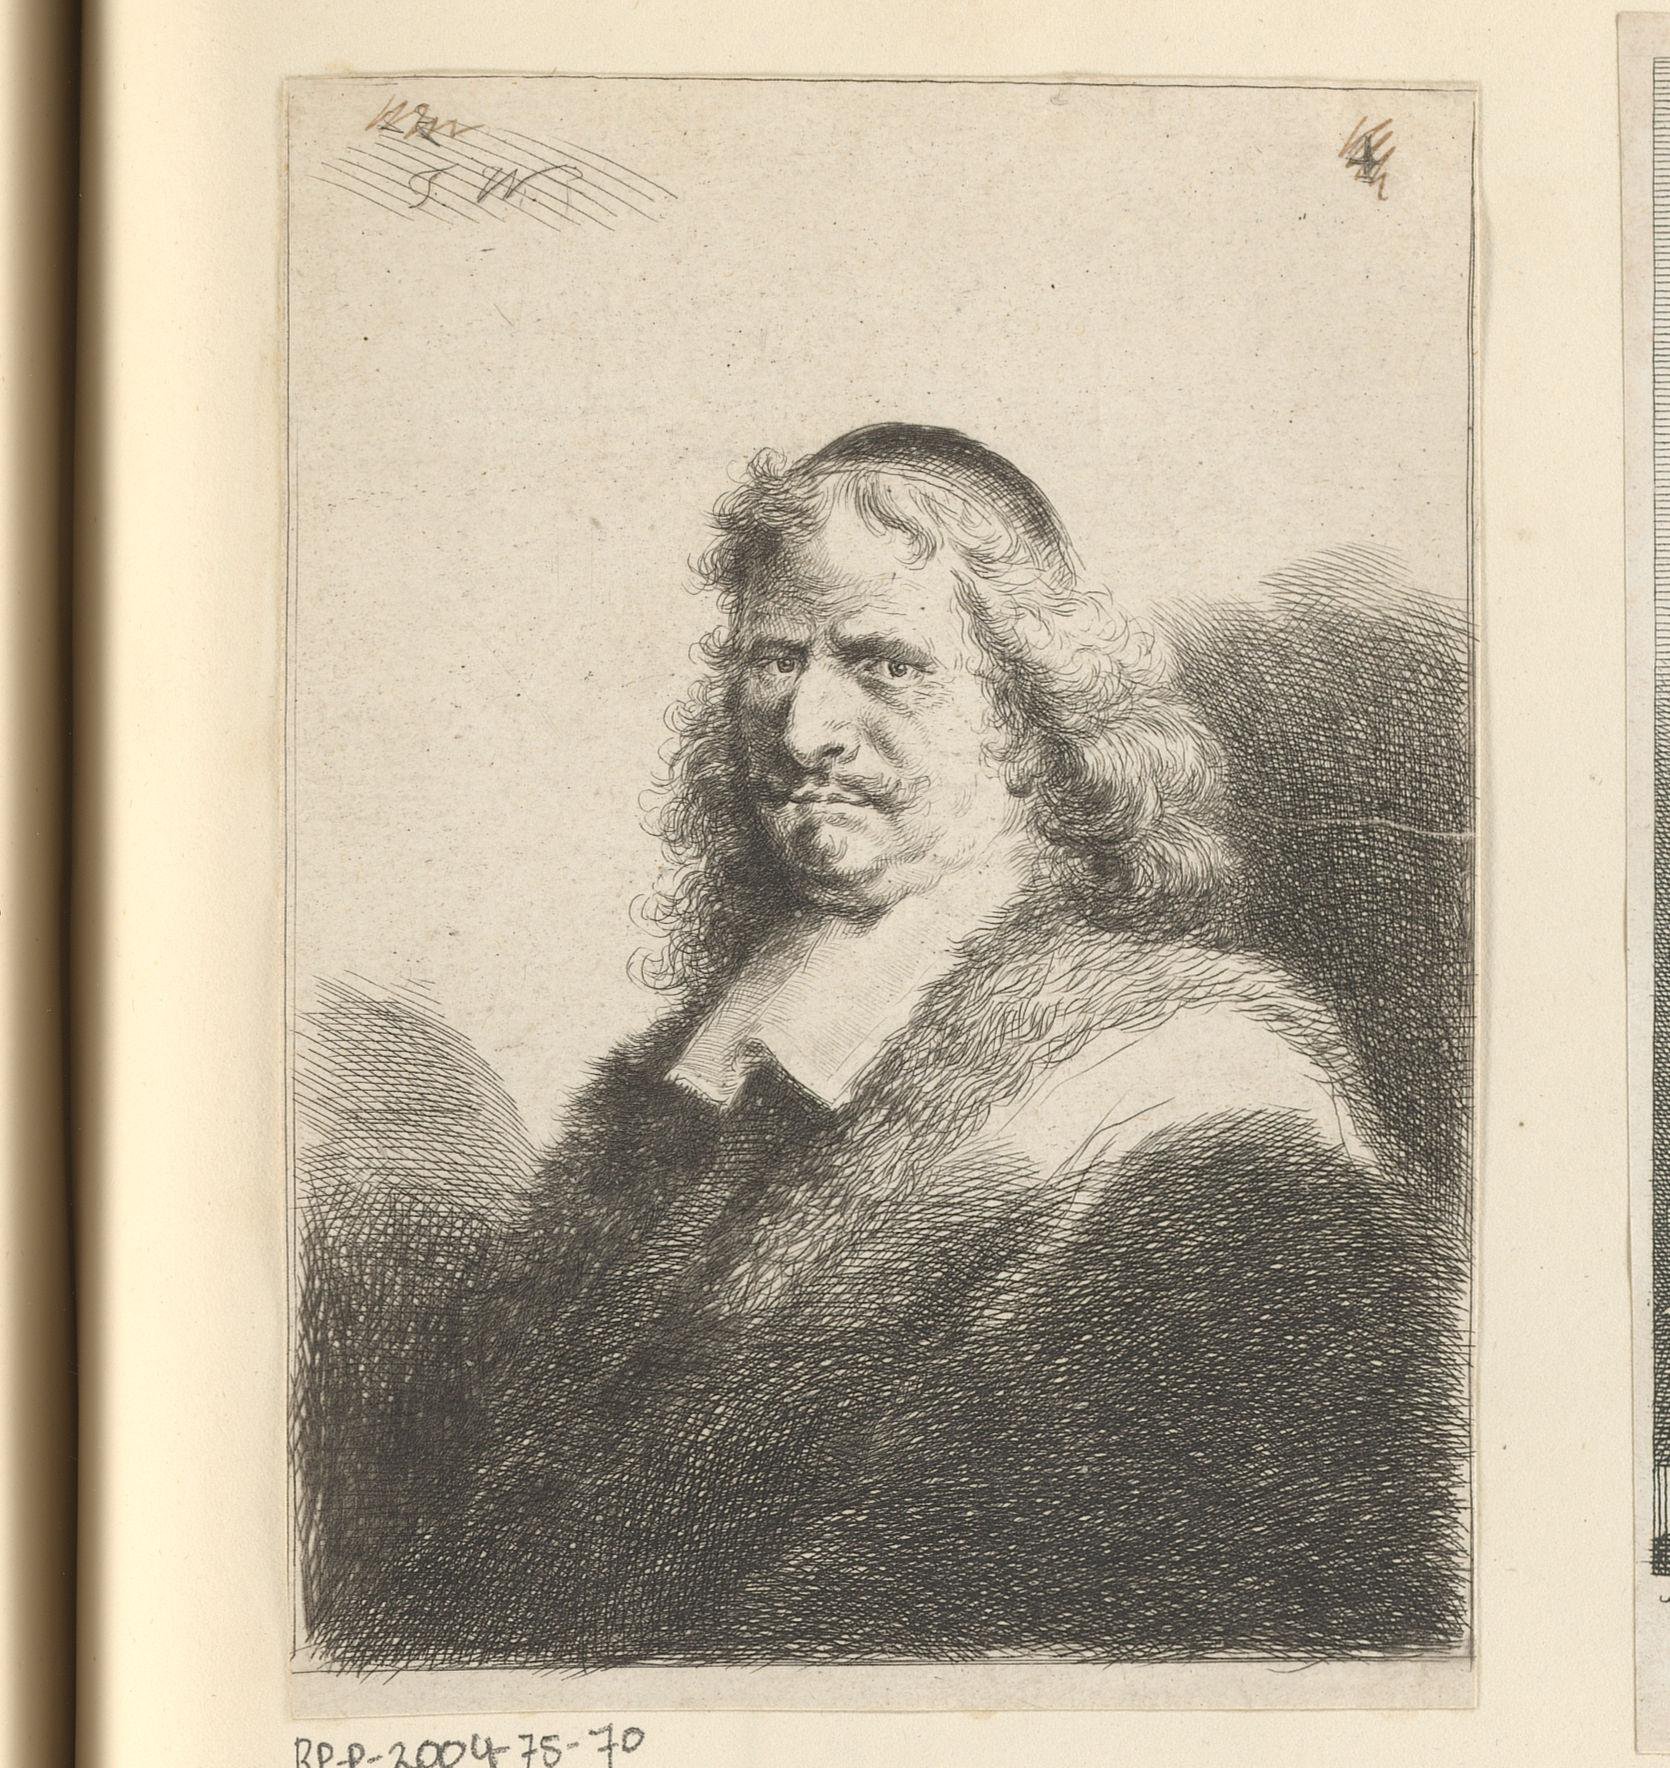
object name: album leaf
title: Portret van een onbekende man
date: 1757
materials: paper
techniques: etching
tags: historical persons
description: De samensteller heeft deze prent in het album geplakt als illustratie bij: Pilkington, Matthew en Johann Heinrich Füssli. A dictionary of painters, from the revival of the art to the present period. 4 dln. Londen: John Crowder, 1805, dl. 4, p. 654.